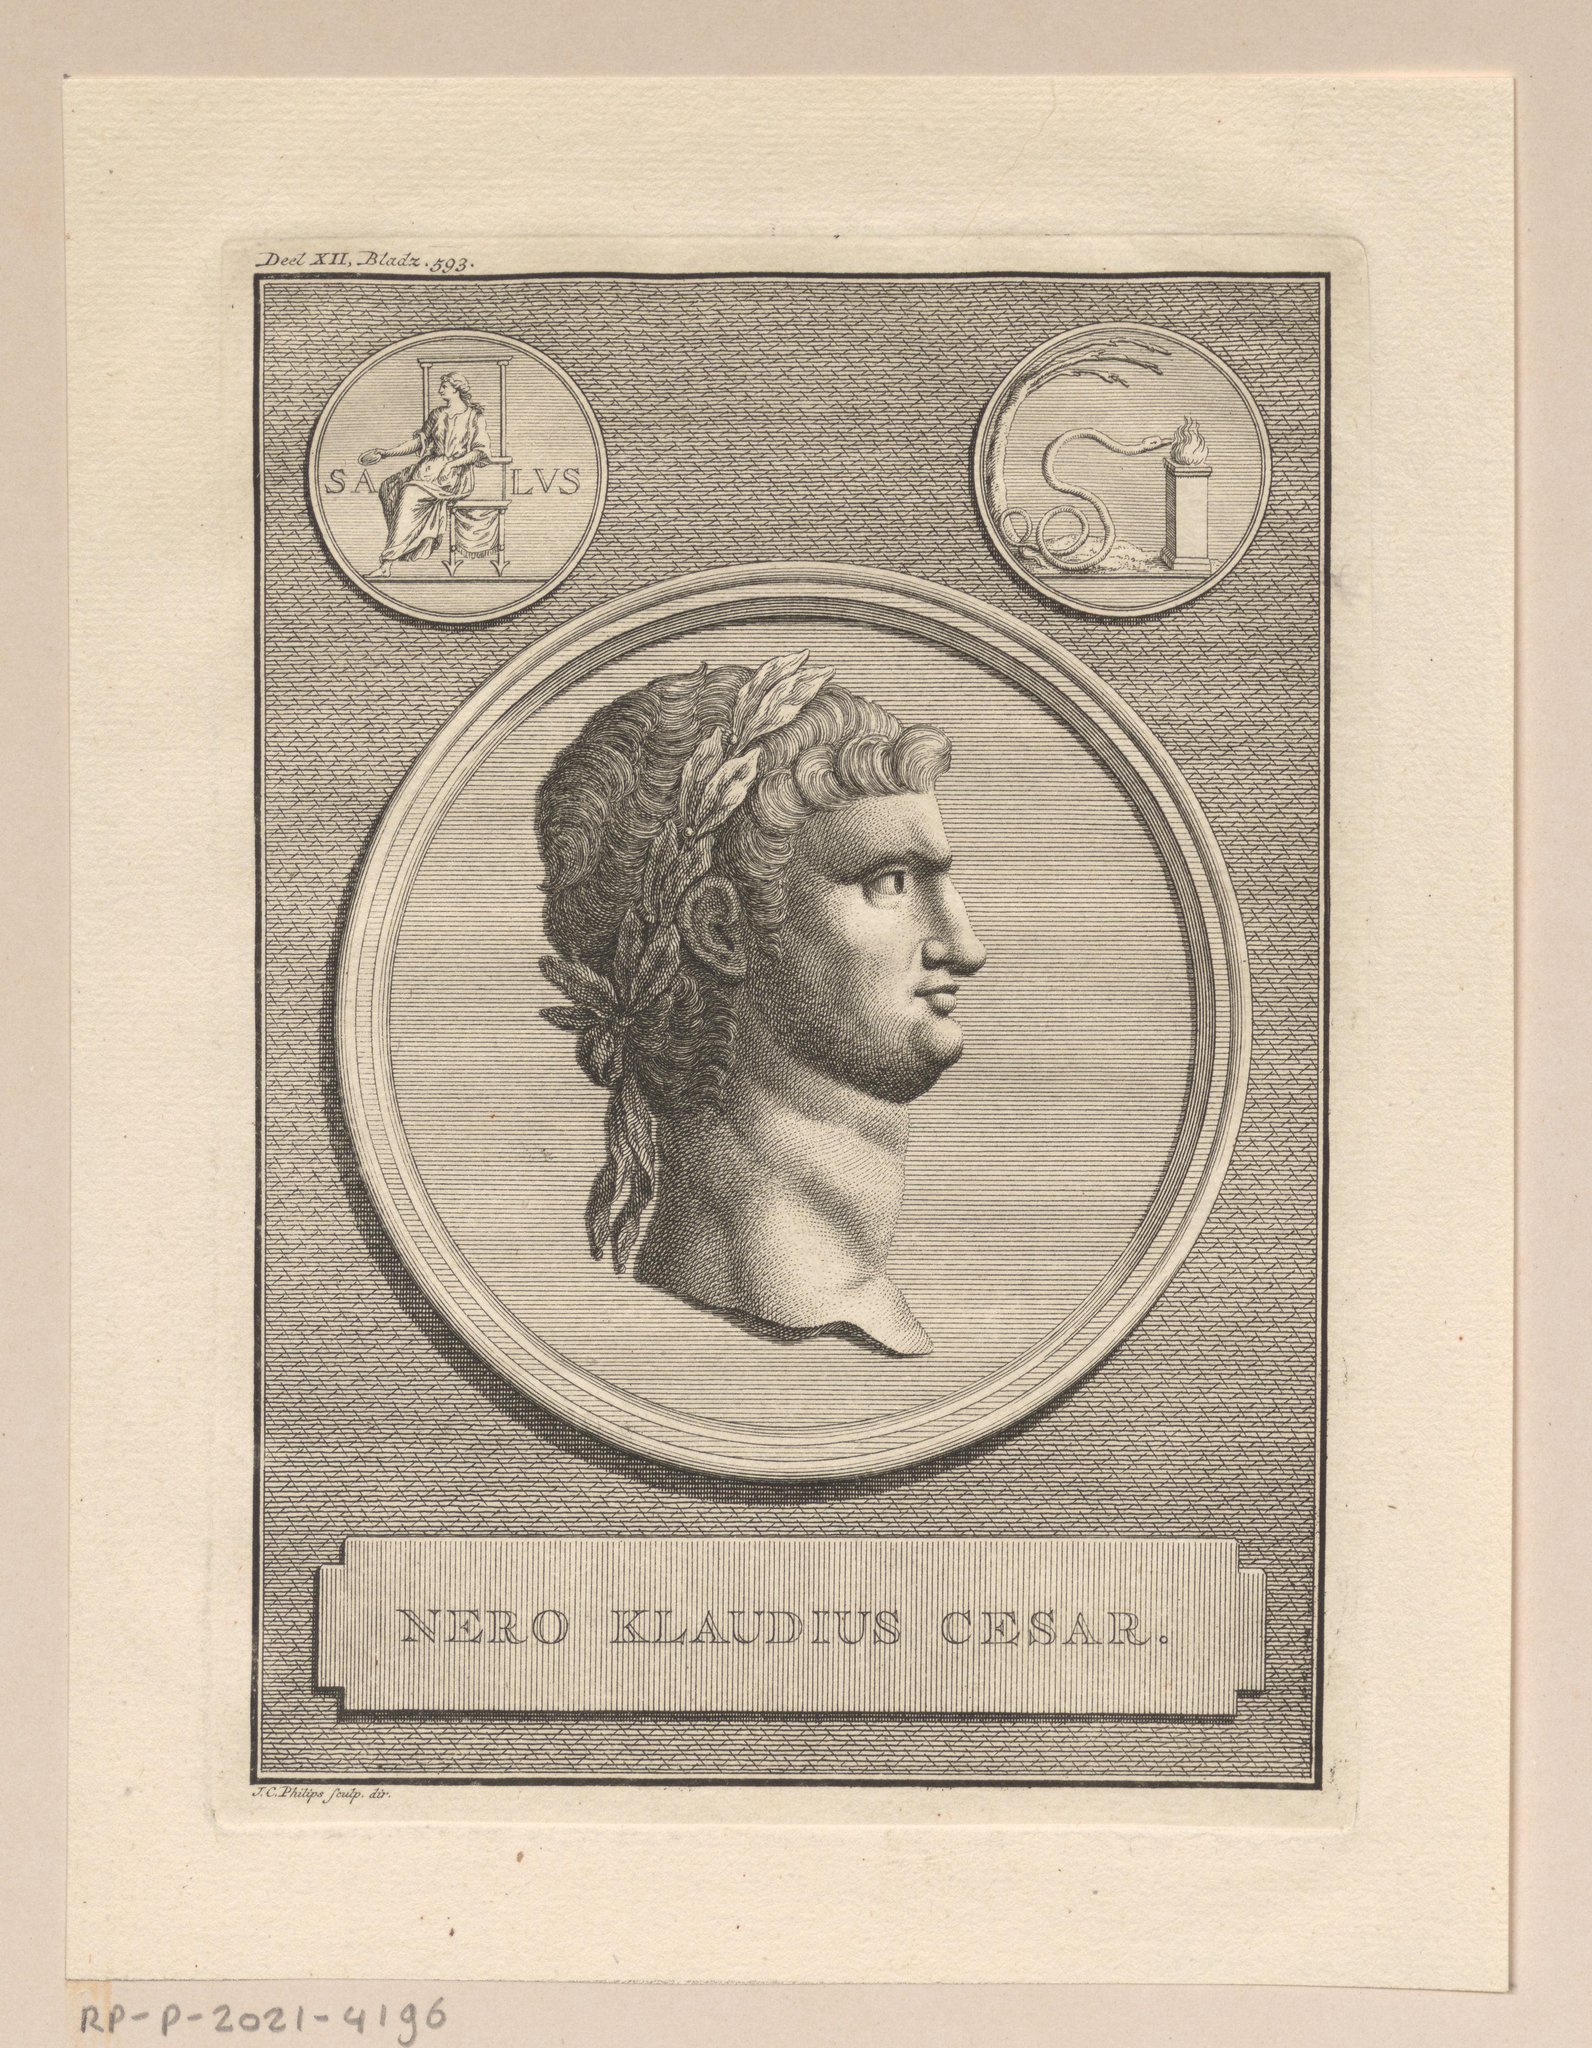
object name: print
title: Portret van Nero, keizer van het Romeinse rijk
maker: jan caspar philips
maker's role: draughtsman, print maker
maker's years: 1700-1775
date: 1746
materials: paper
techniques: engraving, etching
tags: snakes, historical persons, (story of) nero, the roman emperor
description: Prent mogelijk uit: Westerbaen, Kornelis. Algemeene histori van het begin der wereld af tot den tegenwoordigen tijd toe (...). Utrecht: Herman Besseling, 1746, dl. 12.